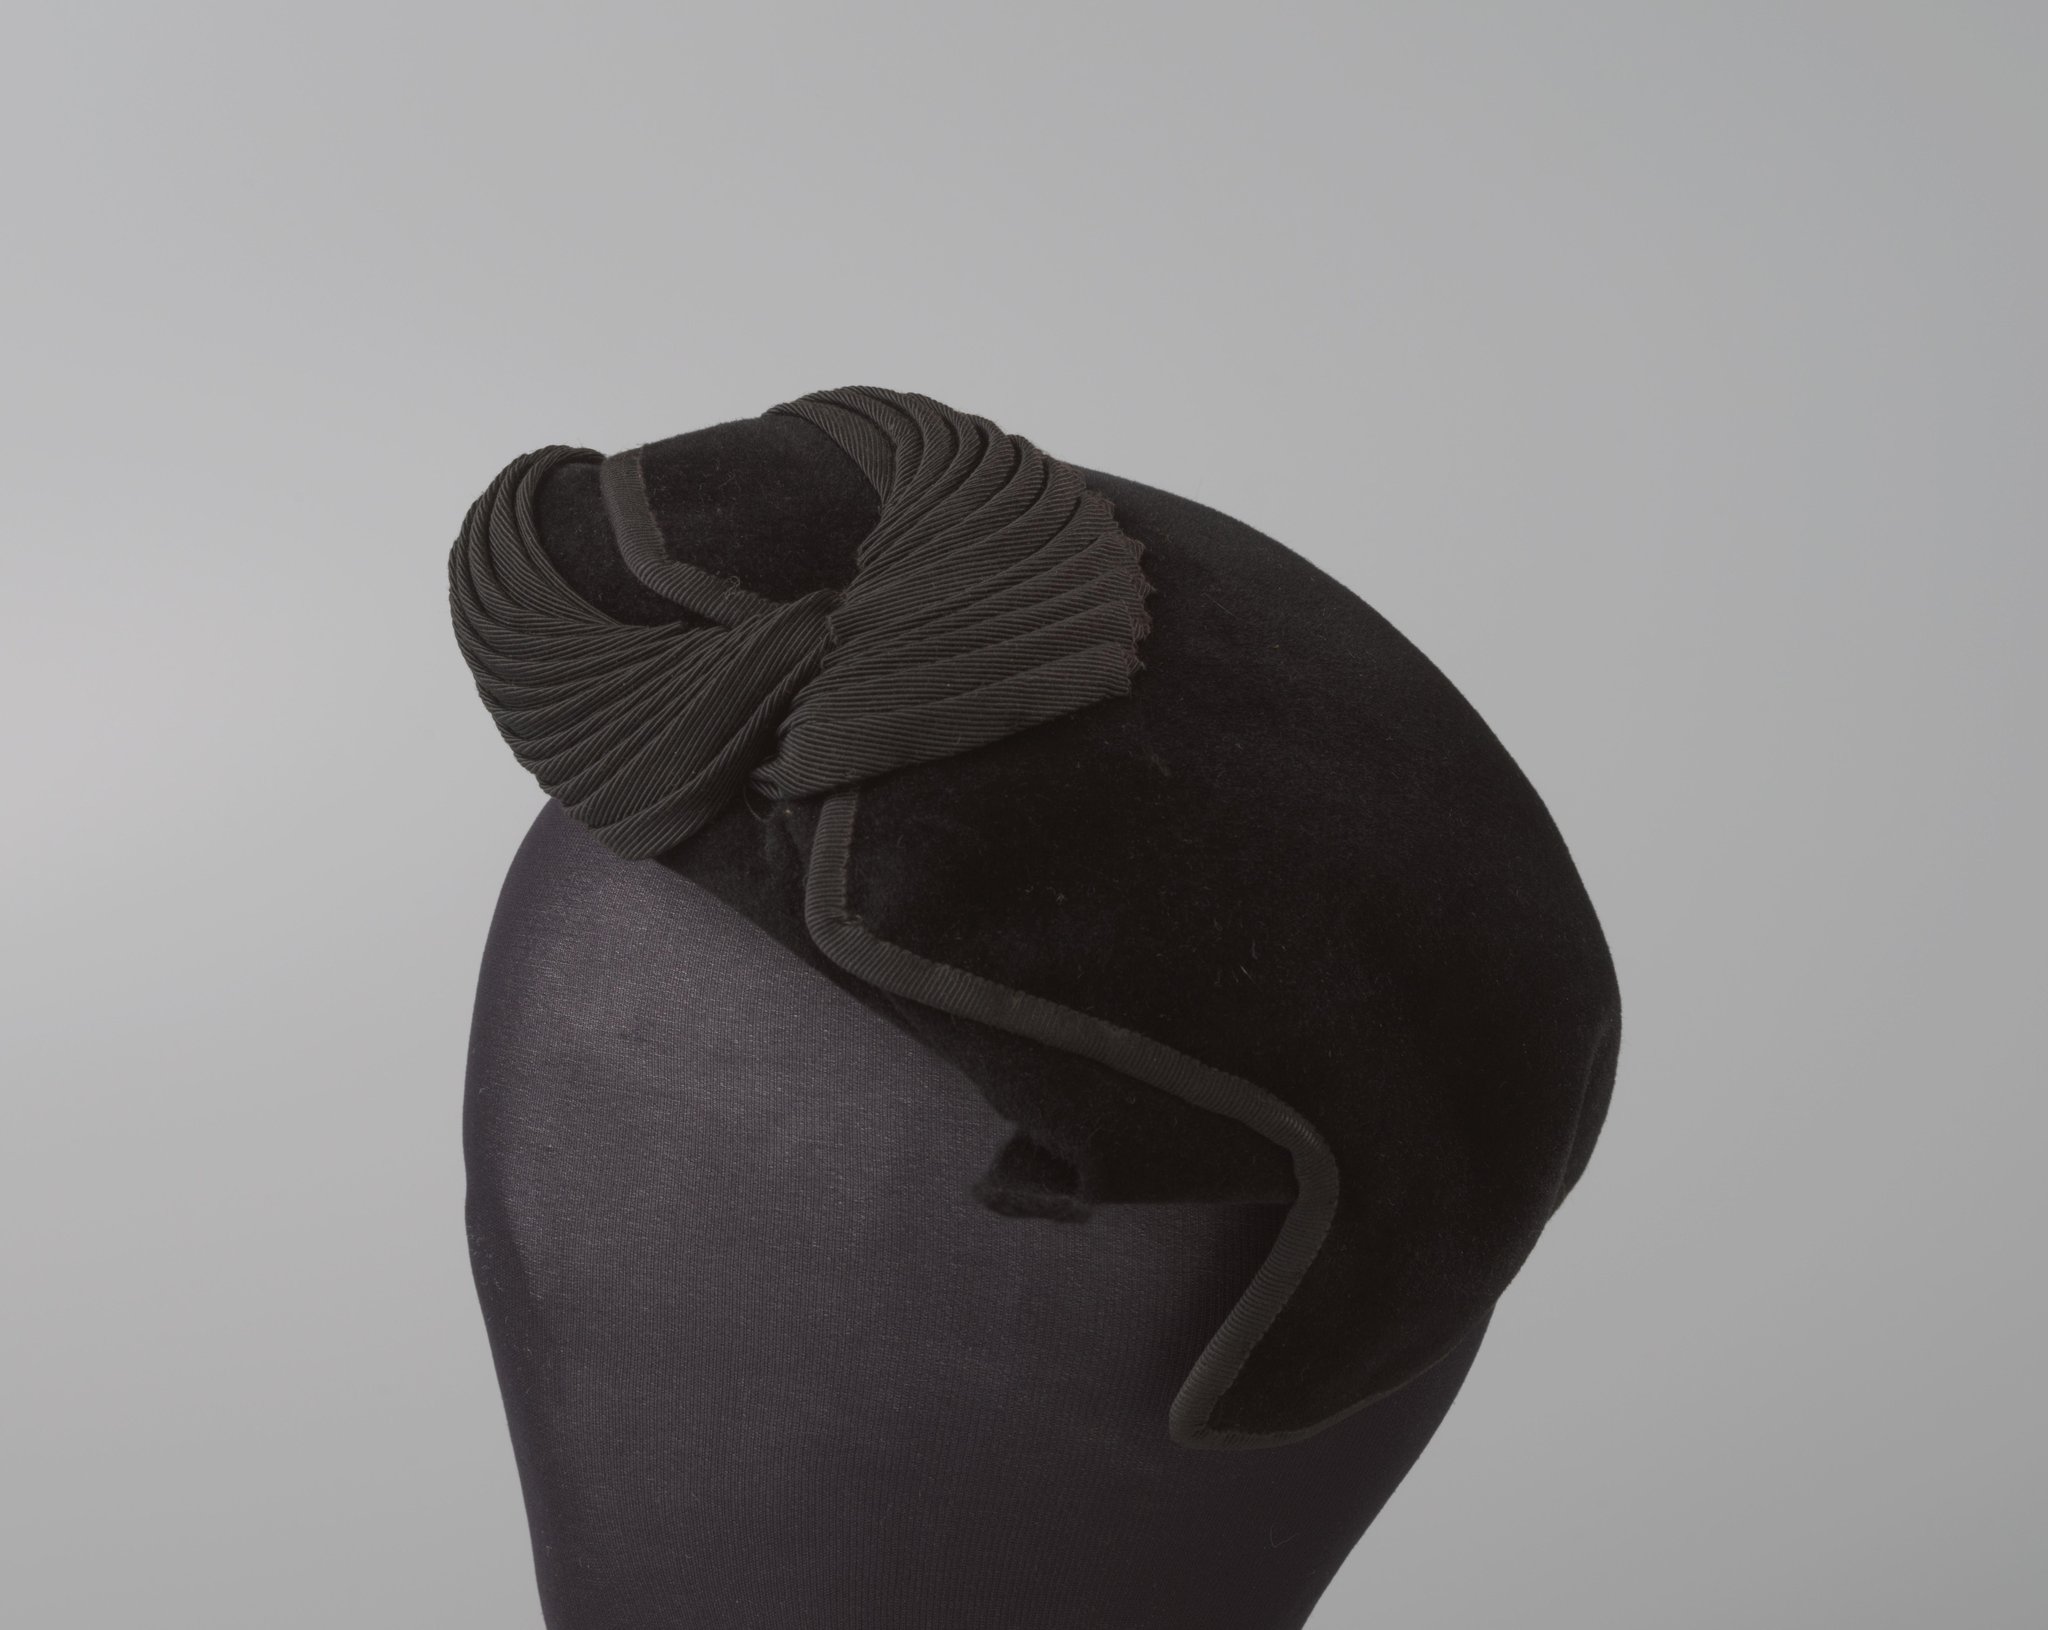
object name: hat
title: Kapje van geschoren zwart vilt, versierd met een gekrulde draperie van zwart ripslint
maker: Anonymous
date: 1950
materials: felt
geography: netherlands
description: Kapje van geschoren zwart vilt, versierd met een gekrulde draperie van zwart ripslint. Plat model, met twee naar beneden gebogen punten aan de achterkant.